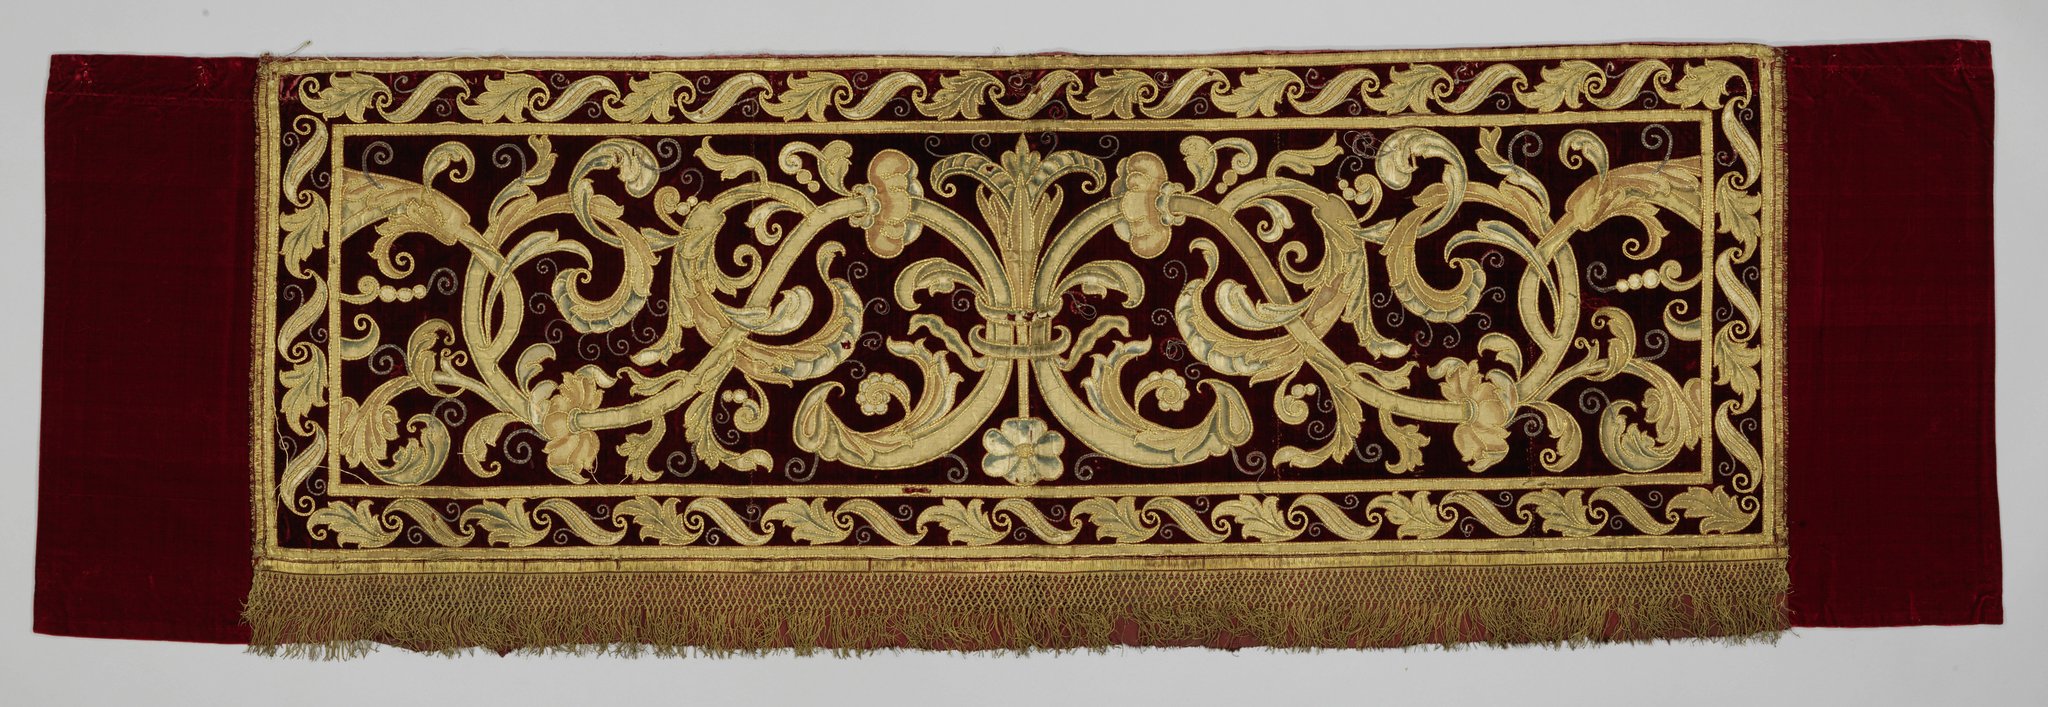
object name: lambrequin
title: Lambrekijn of strook van applicatie borduurwerk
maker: Anonymous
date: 1500-1599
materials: gold thread, silk, velvet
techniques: embroidered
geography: italy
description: Lambrekijn of strook van applicatie-borduurwerk op een wijnrode fluwelen fond. Het patroon heeft symmetrische liggende S-ranken, in het midden samengebonden met een lelie en een roos. De rijk vertakte rank is met bladrozetten bezet en eindigt in voluten van acanthusbladeren en zilveren hechtranken. De strook is afgewerkt met goudpassement en goudfranje langs de onderzijde. De strook hoort bij drie stroken (BK-17292-A t/m BK-17292-D).